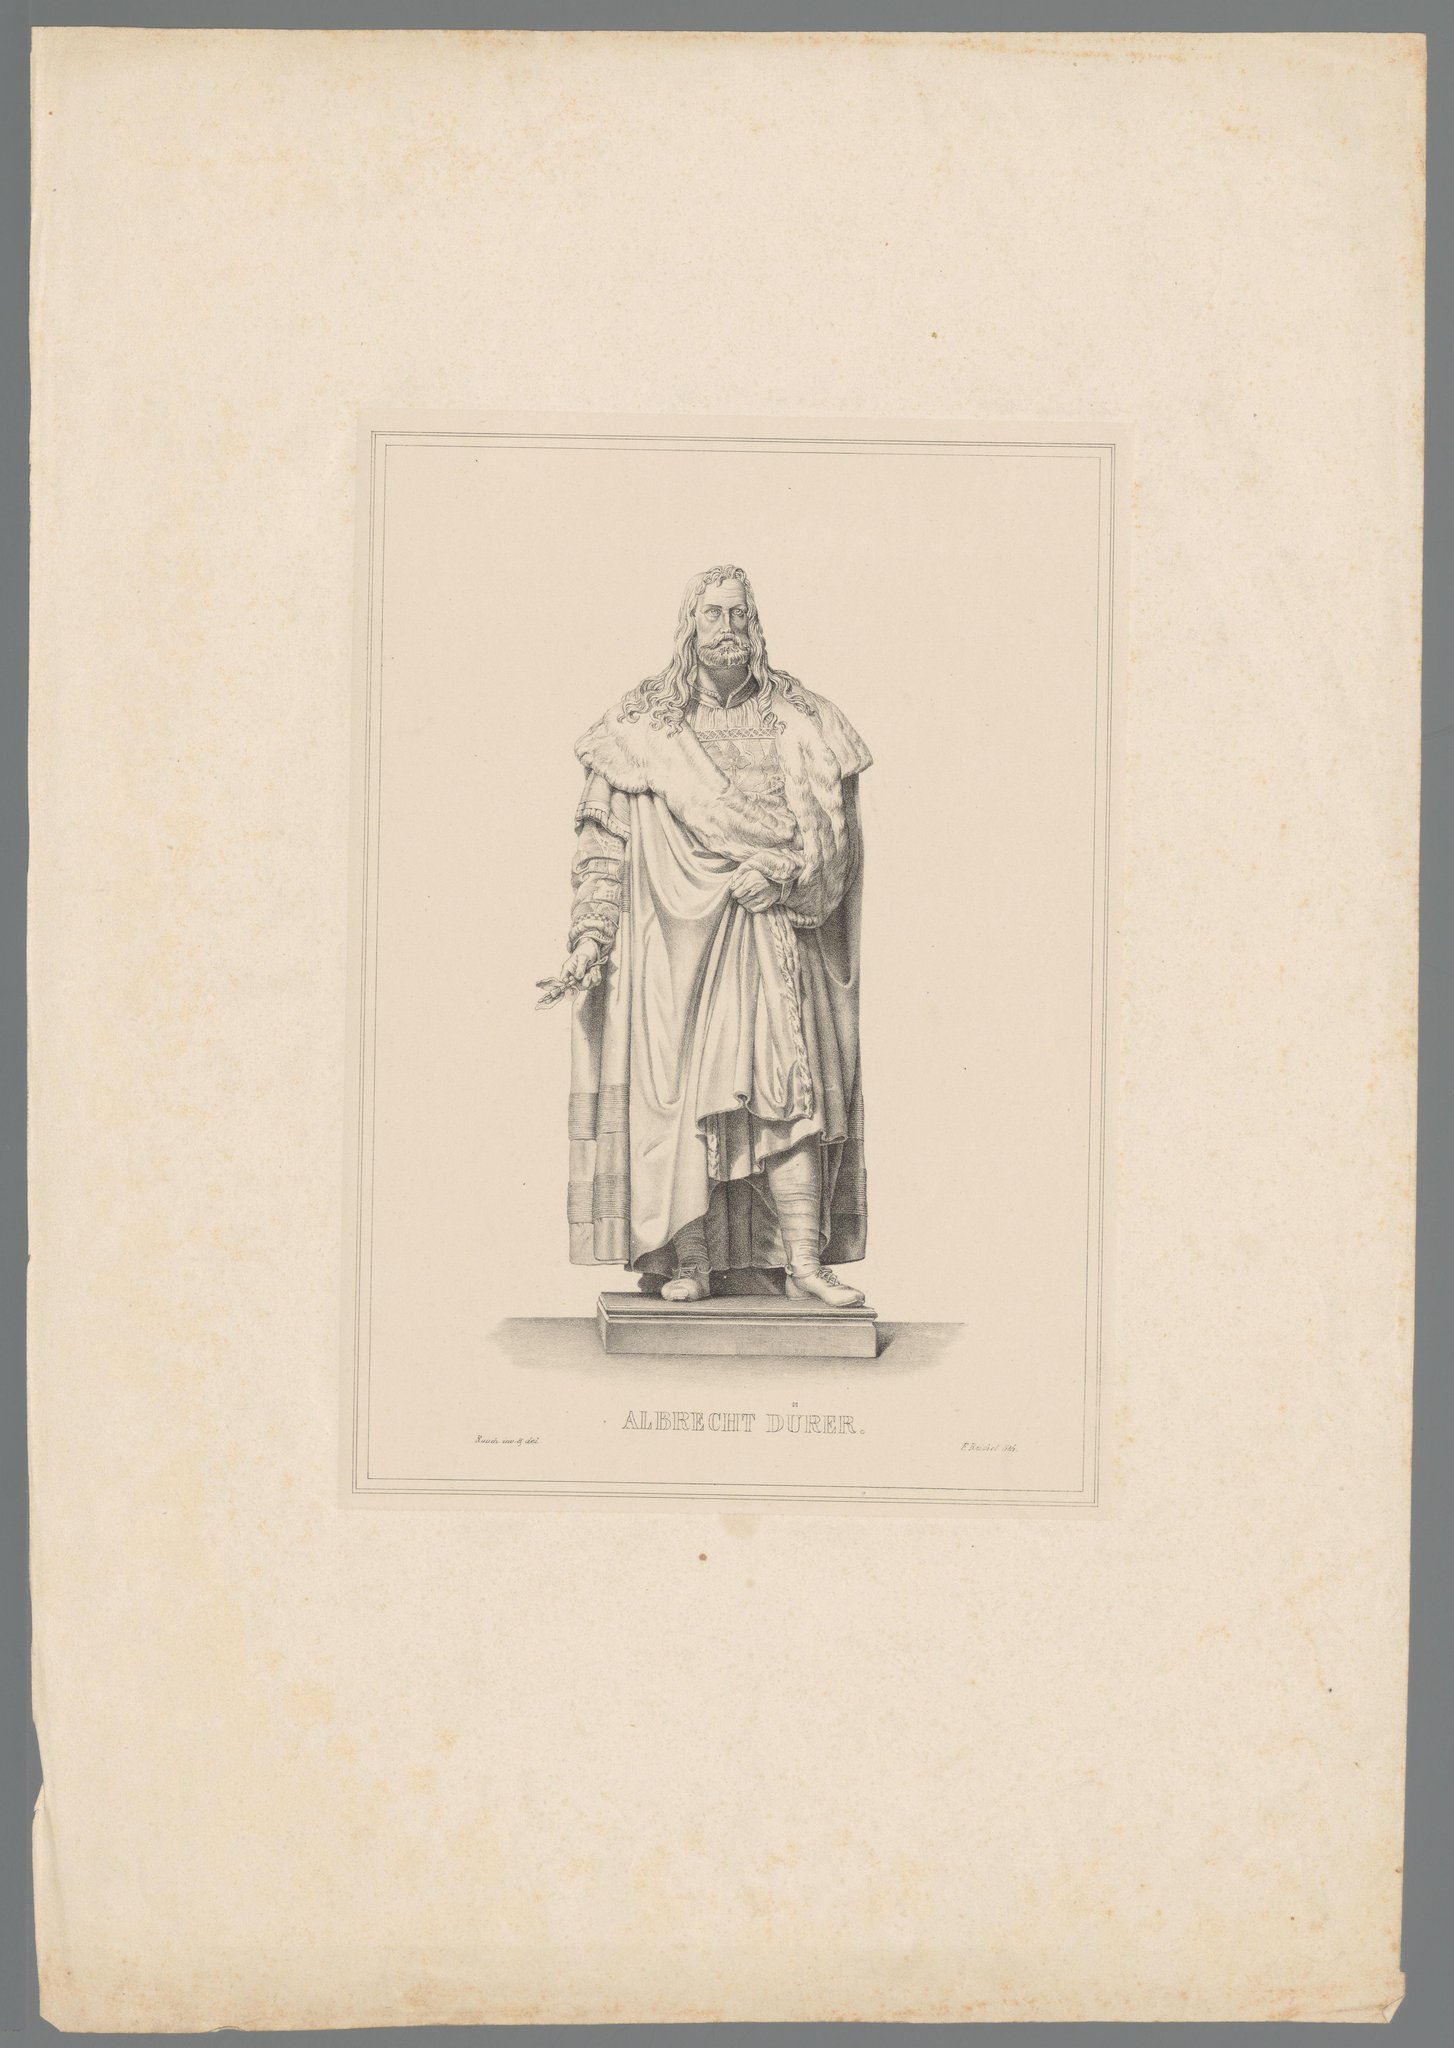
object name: print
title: Portret van Albrecht Dürer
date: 1783-1844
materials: paper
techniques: lithograph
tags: painter, print maker, draughtsman, albrecht dürer, historical persons, portrait, self-portrait of artist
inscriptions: collector's mark: Lugt 2228